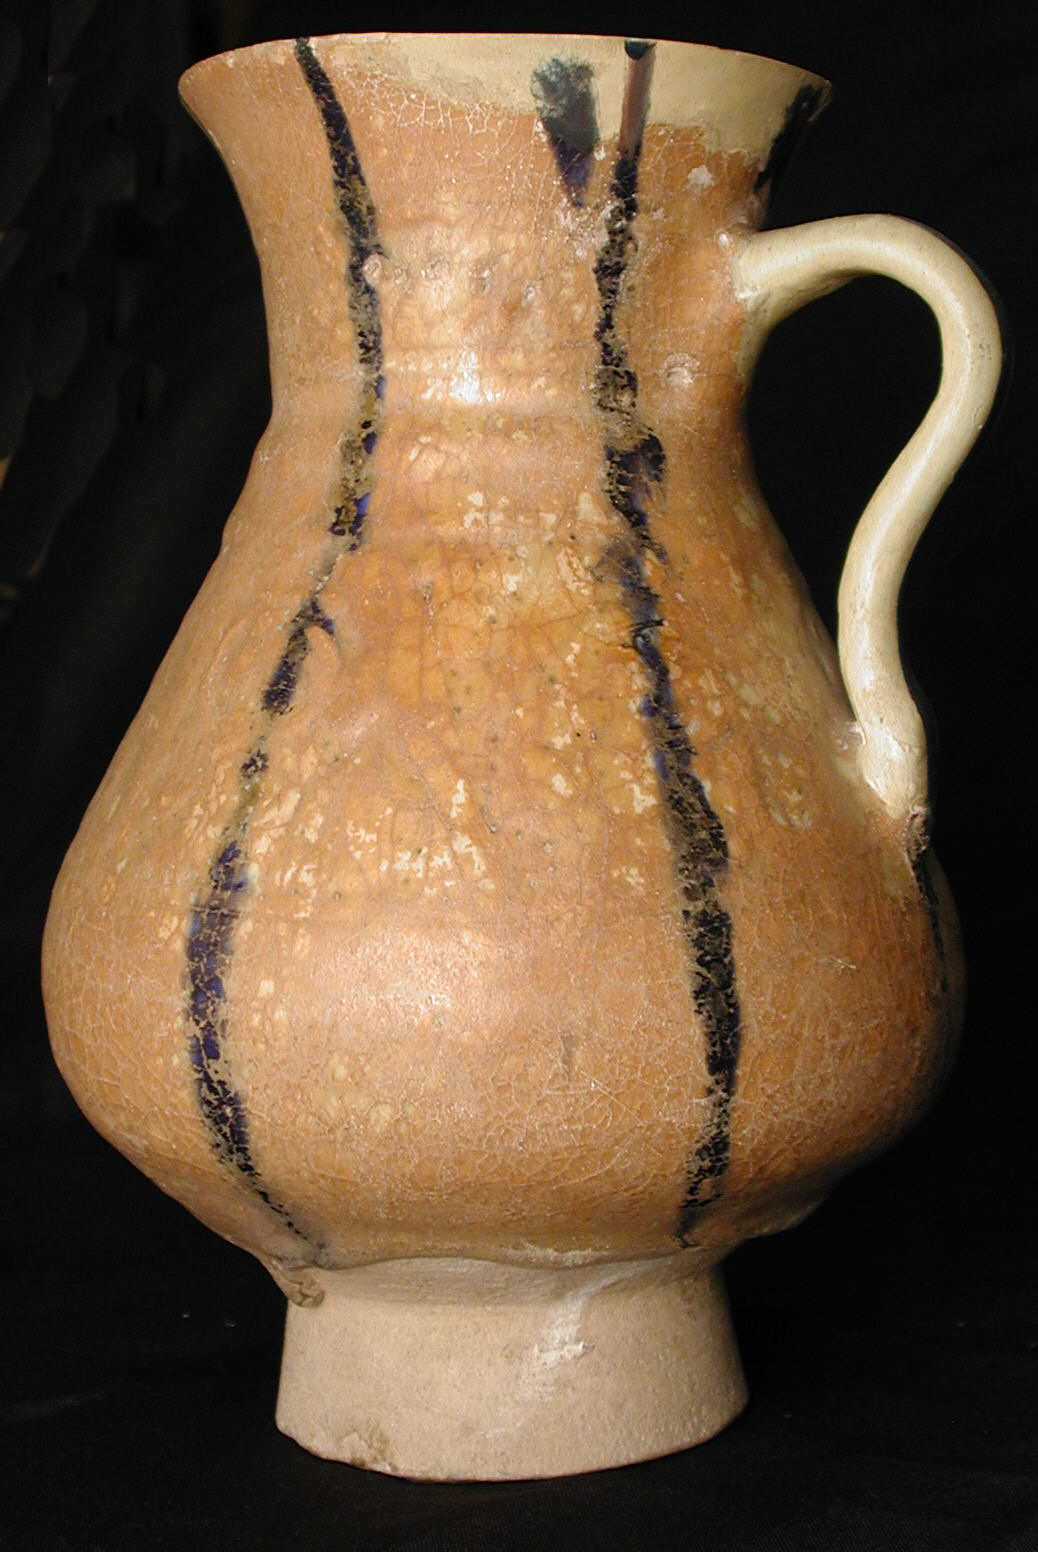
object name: ewer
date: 1101-1300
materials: stonepaste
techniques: glazing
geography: iran